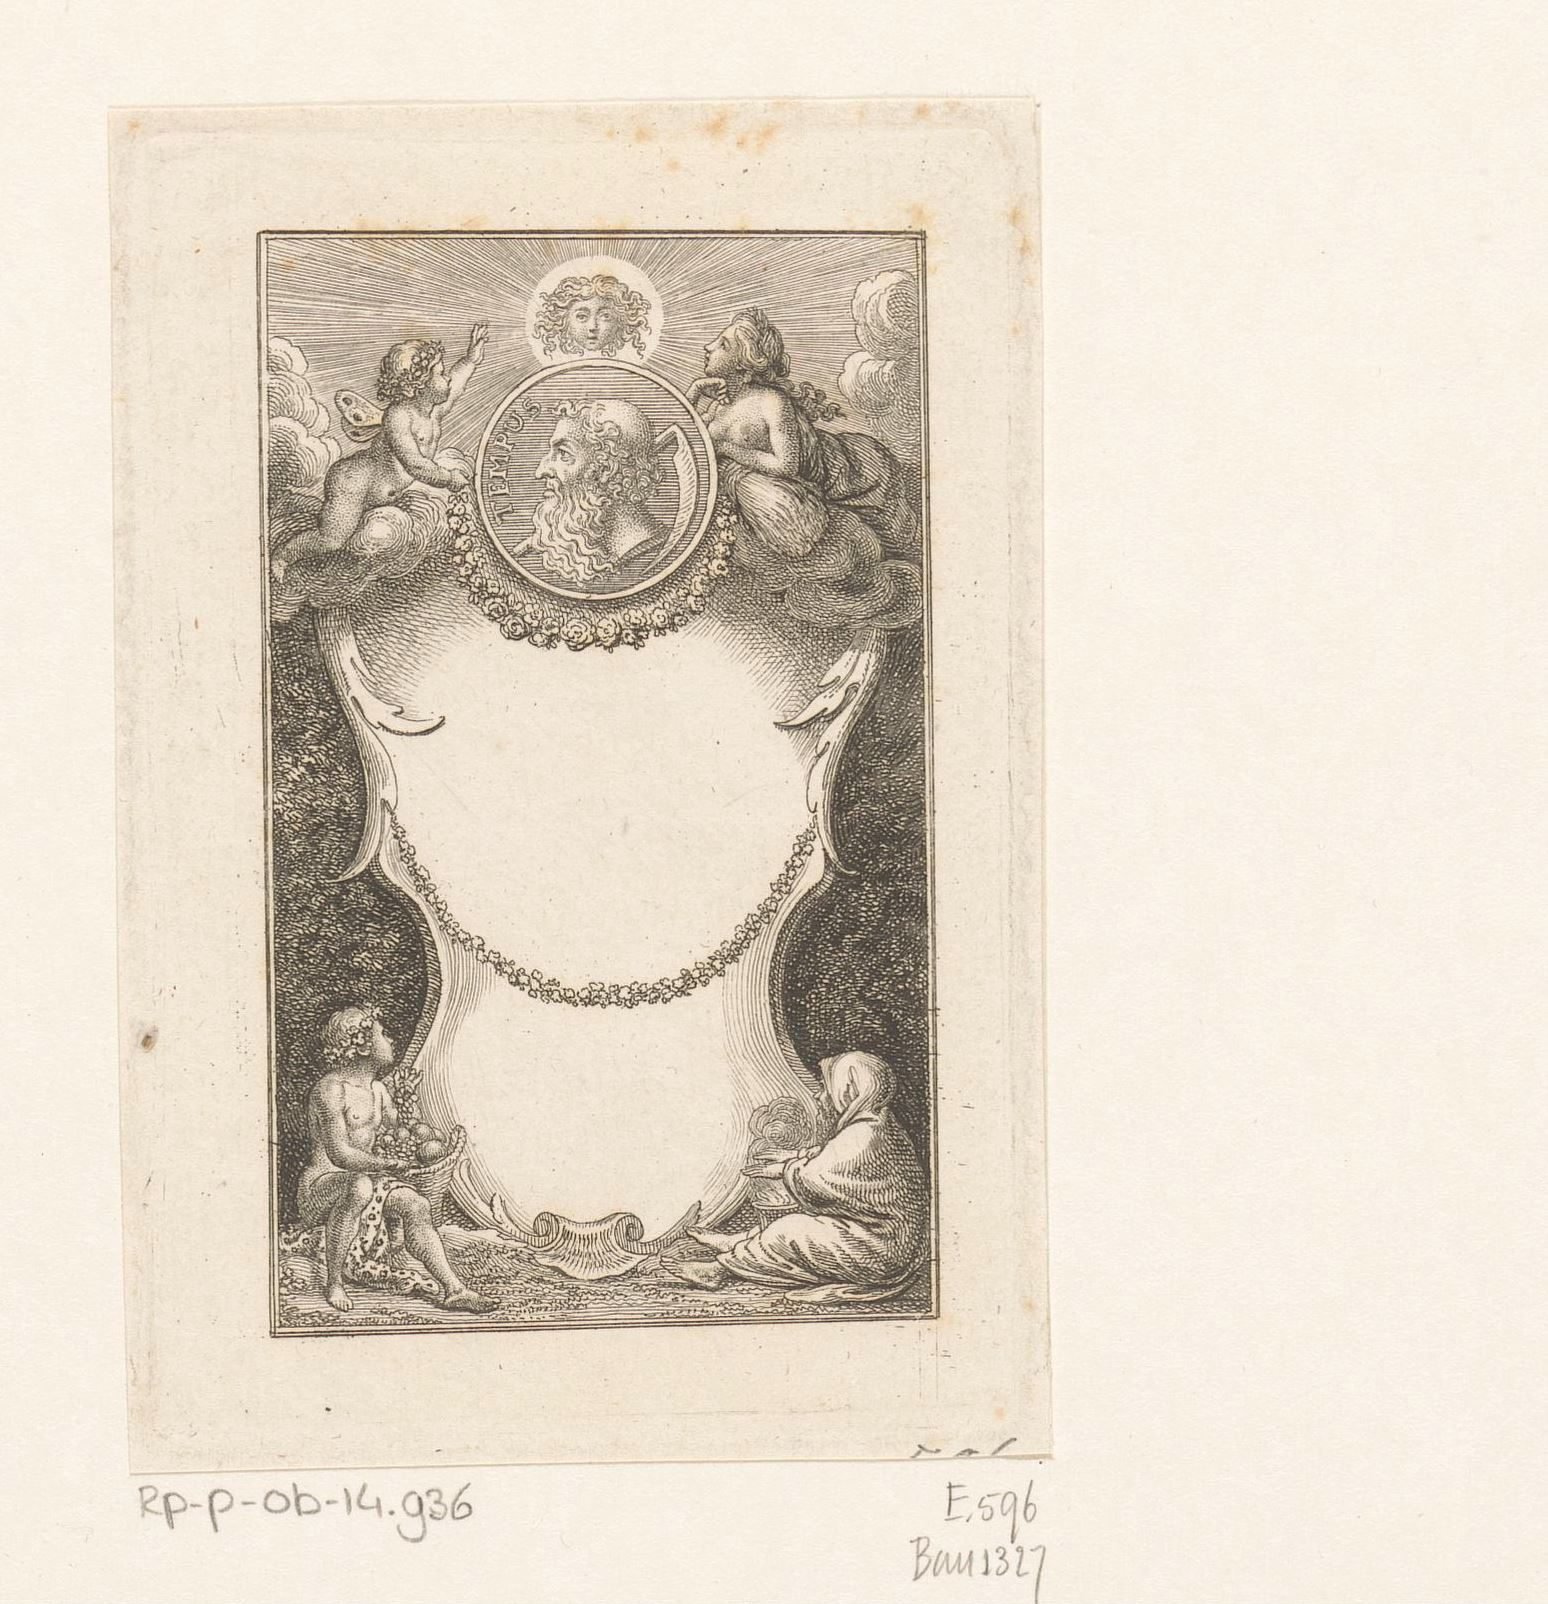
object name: titelblad, titelpagina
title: Titelpagina voor: Grosbritannischer Historischer Genealogischer Calender für 1789, 1788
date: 1788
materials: paper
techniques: etching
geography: berlin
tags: (story of) saturn (cronus) - attributes, year divided into four seasons, sun represented as face, wheel, etc., ornament ~ cartouche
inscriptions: collector's mark: Lugt 2228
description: Latere staat van deze prent gebruikt in: Königl. Grosbritannischer Historischer Genealogischer Calender für 1789, mit Kupfern von Chodowiecki. Lauenburg: J. G. Berenberg, 1788.